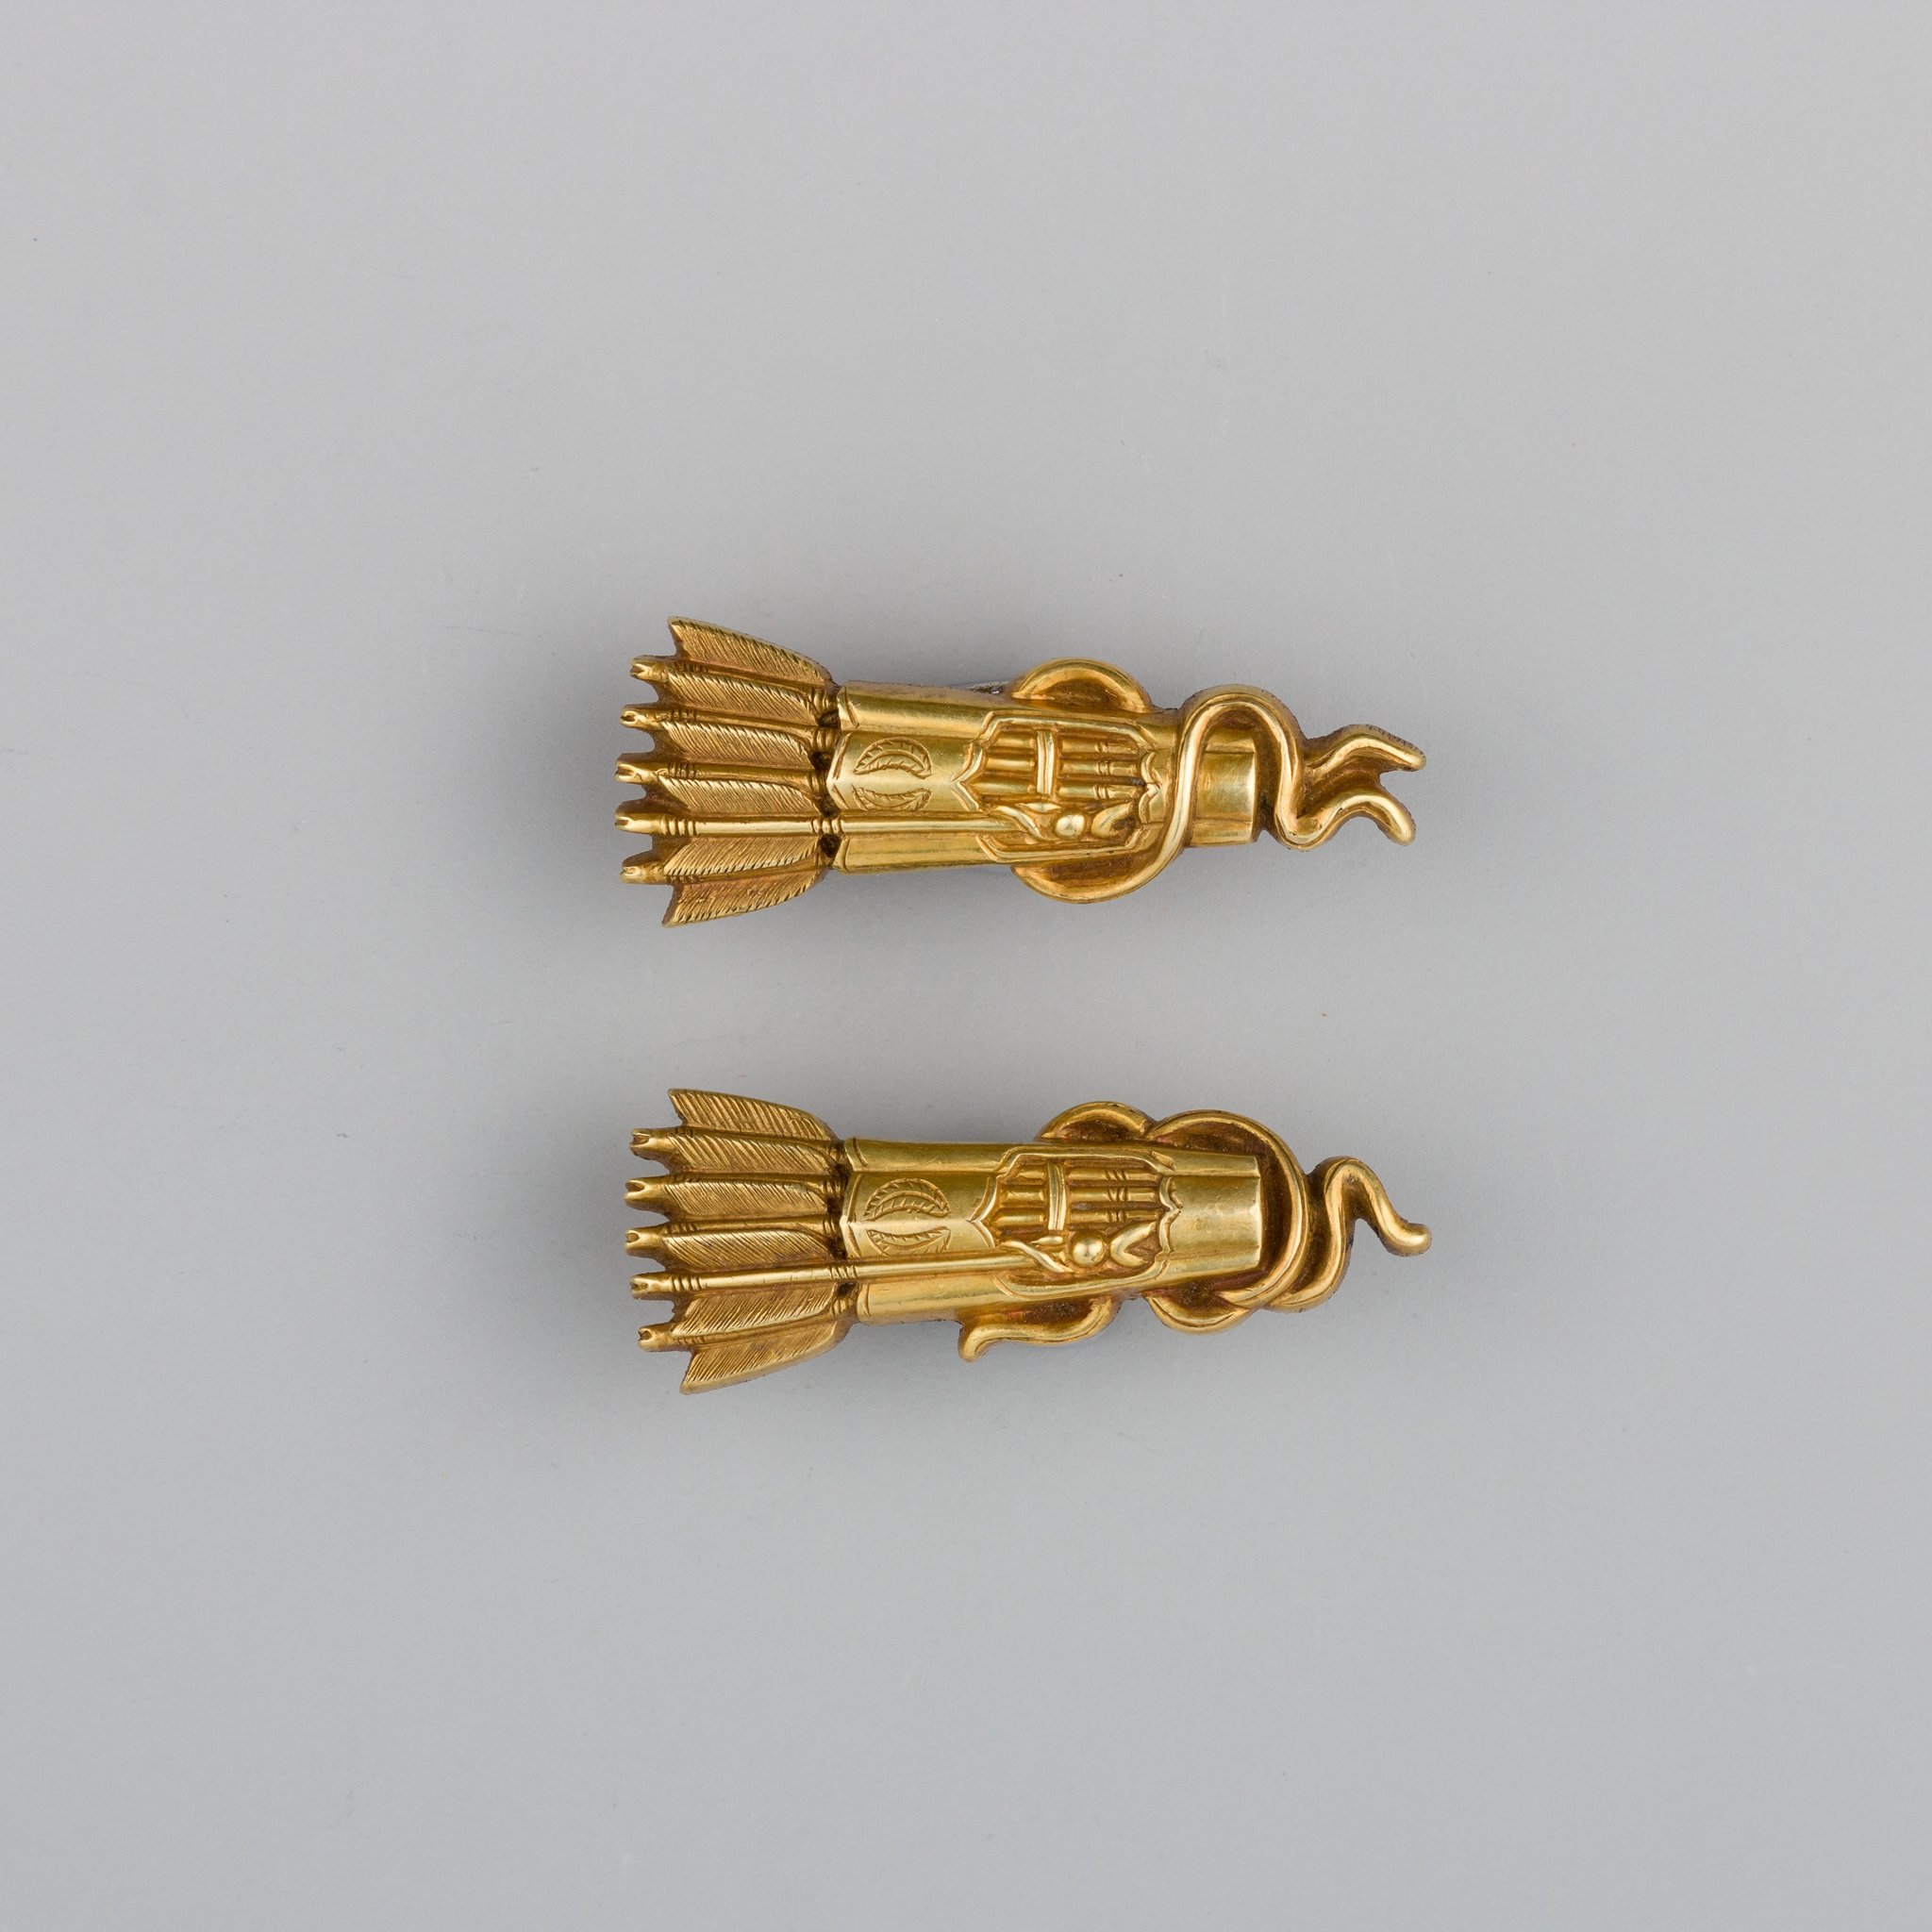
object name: pair of sword grip ornament menuki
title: Pair of Sword-Grip Ornaments (Menuki)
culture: japanese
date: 1701-1800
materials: gold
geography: japan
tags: arrows